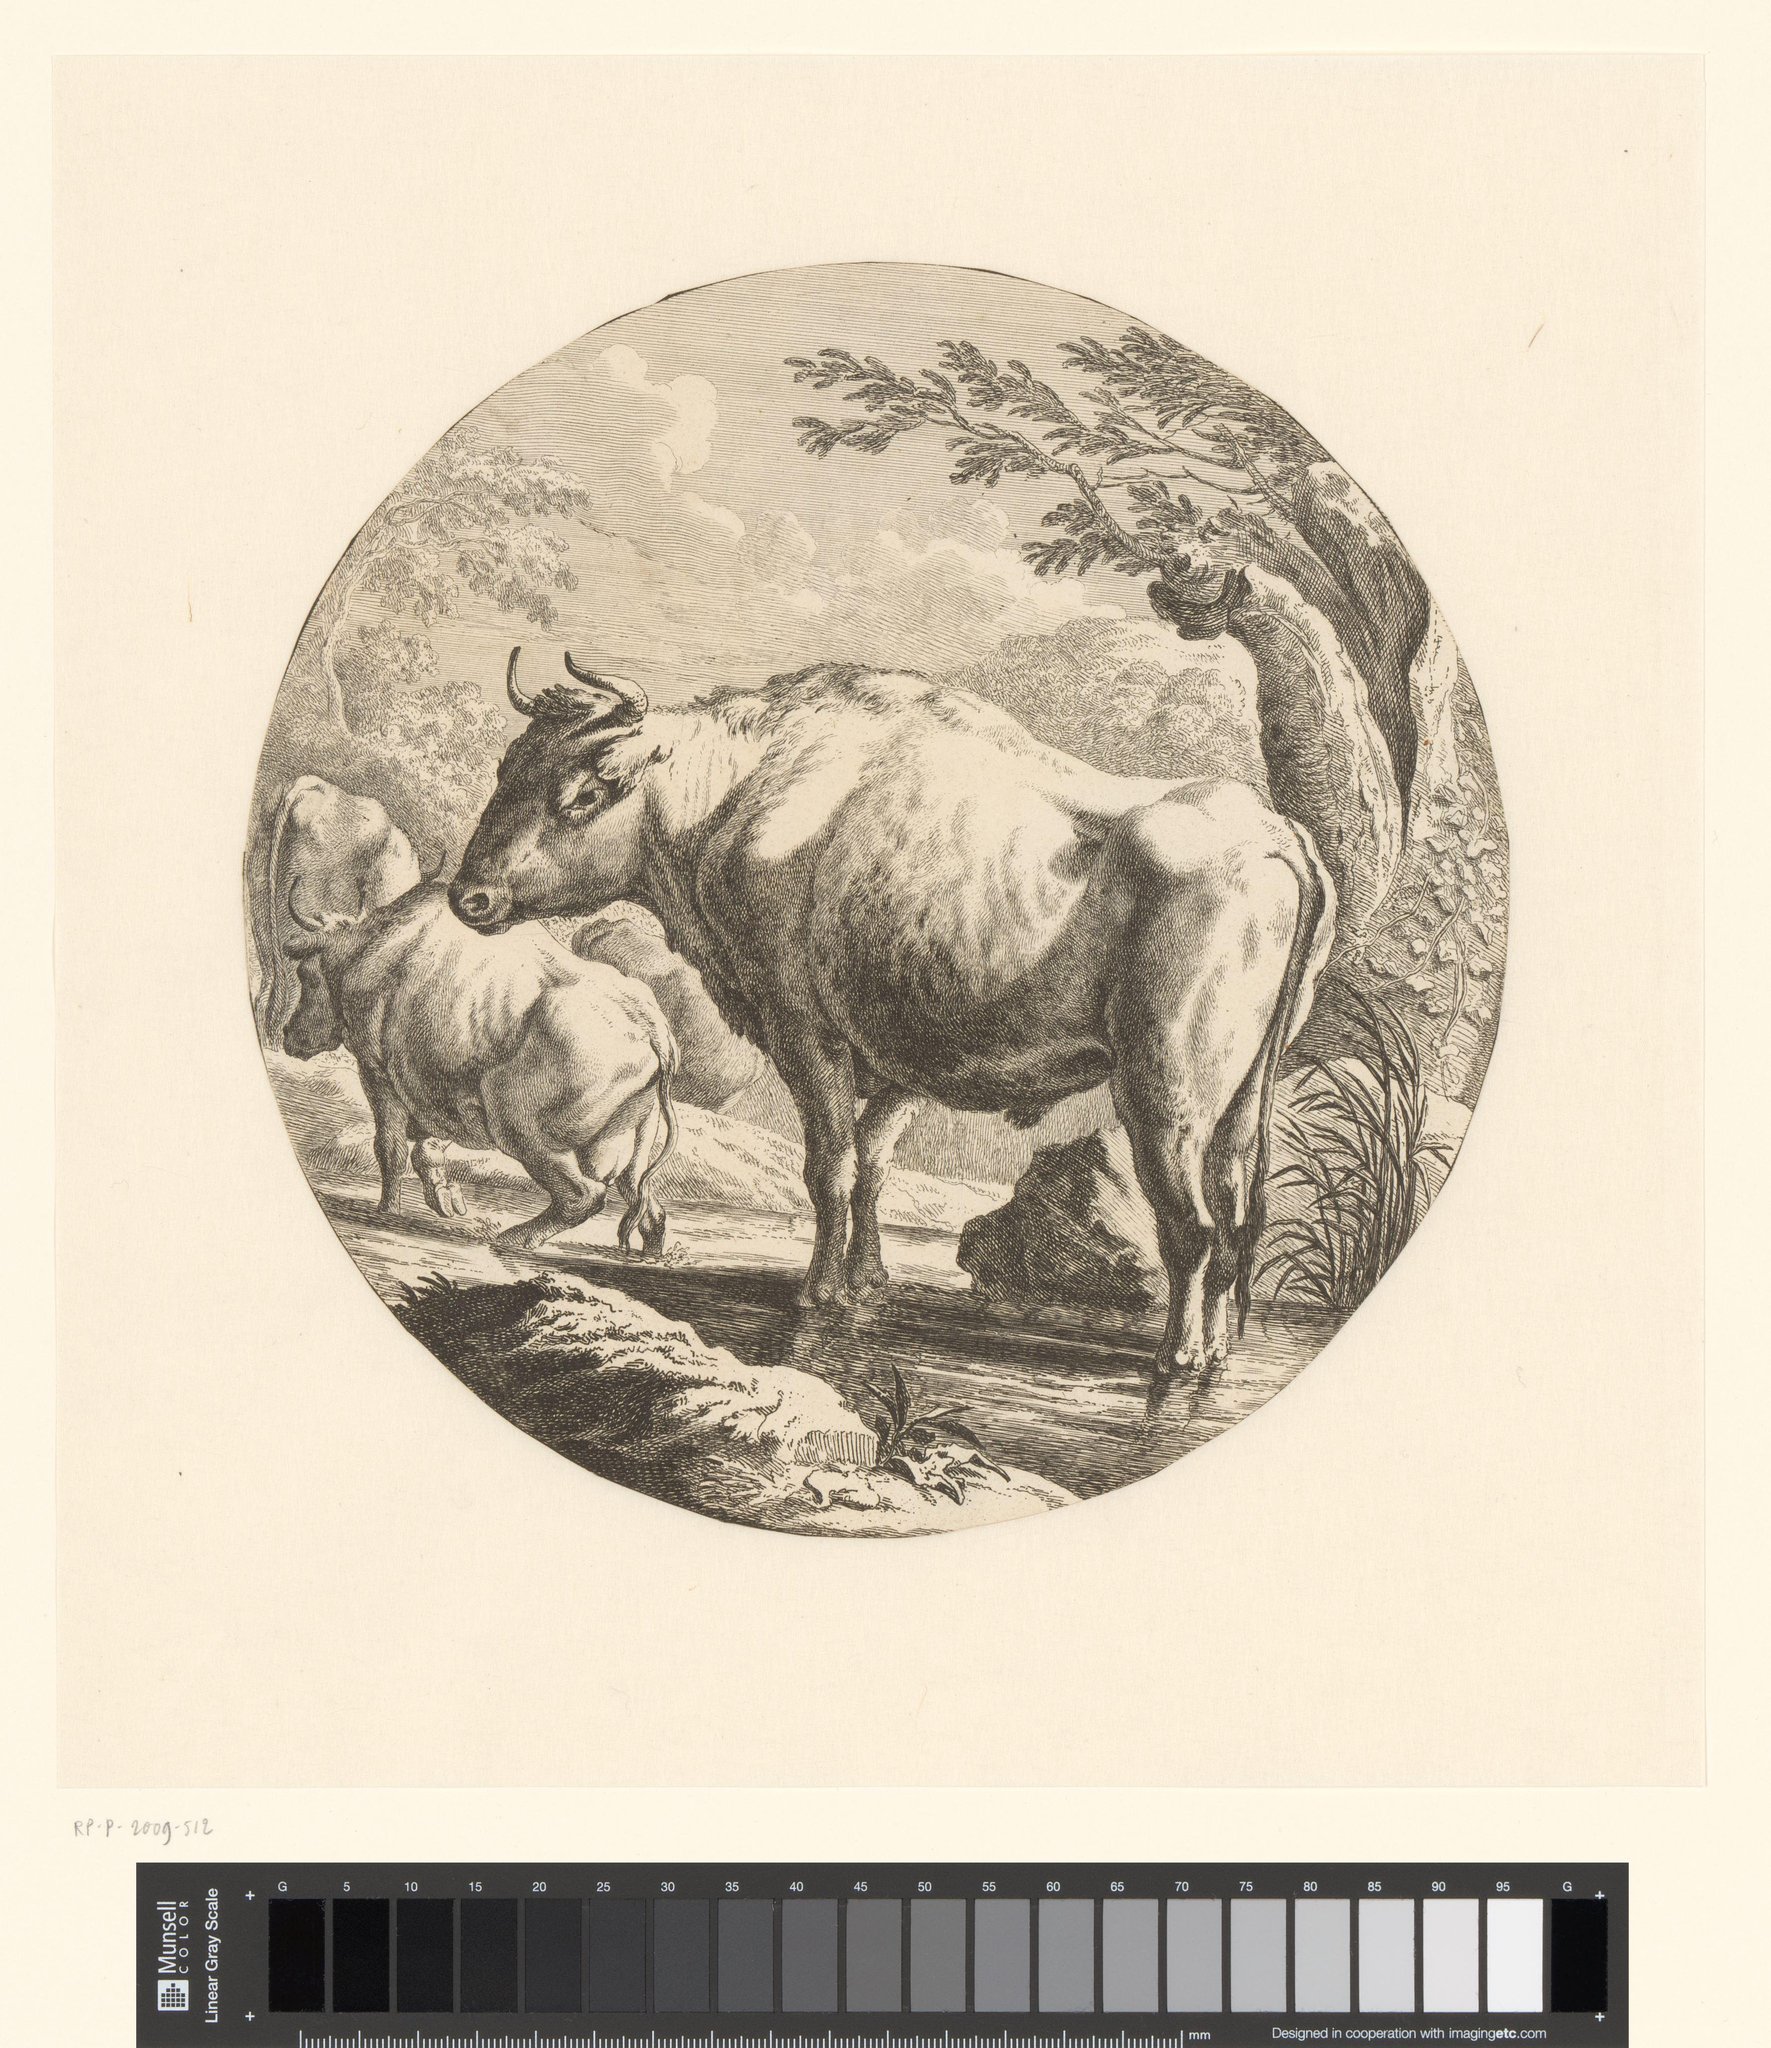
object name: print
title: Stier en koeien in een rivier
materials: paper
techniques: etching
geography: augsburg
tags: bovine cattle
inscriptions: collector's mark: Lugt 2228